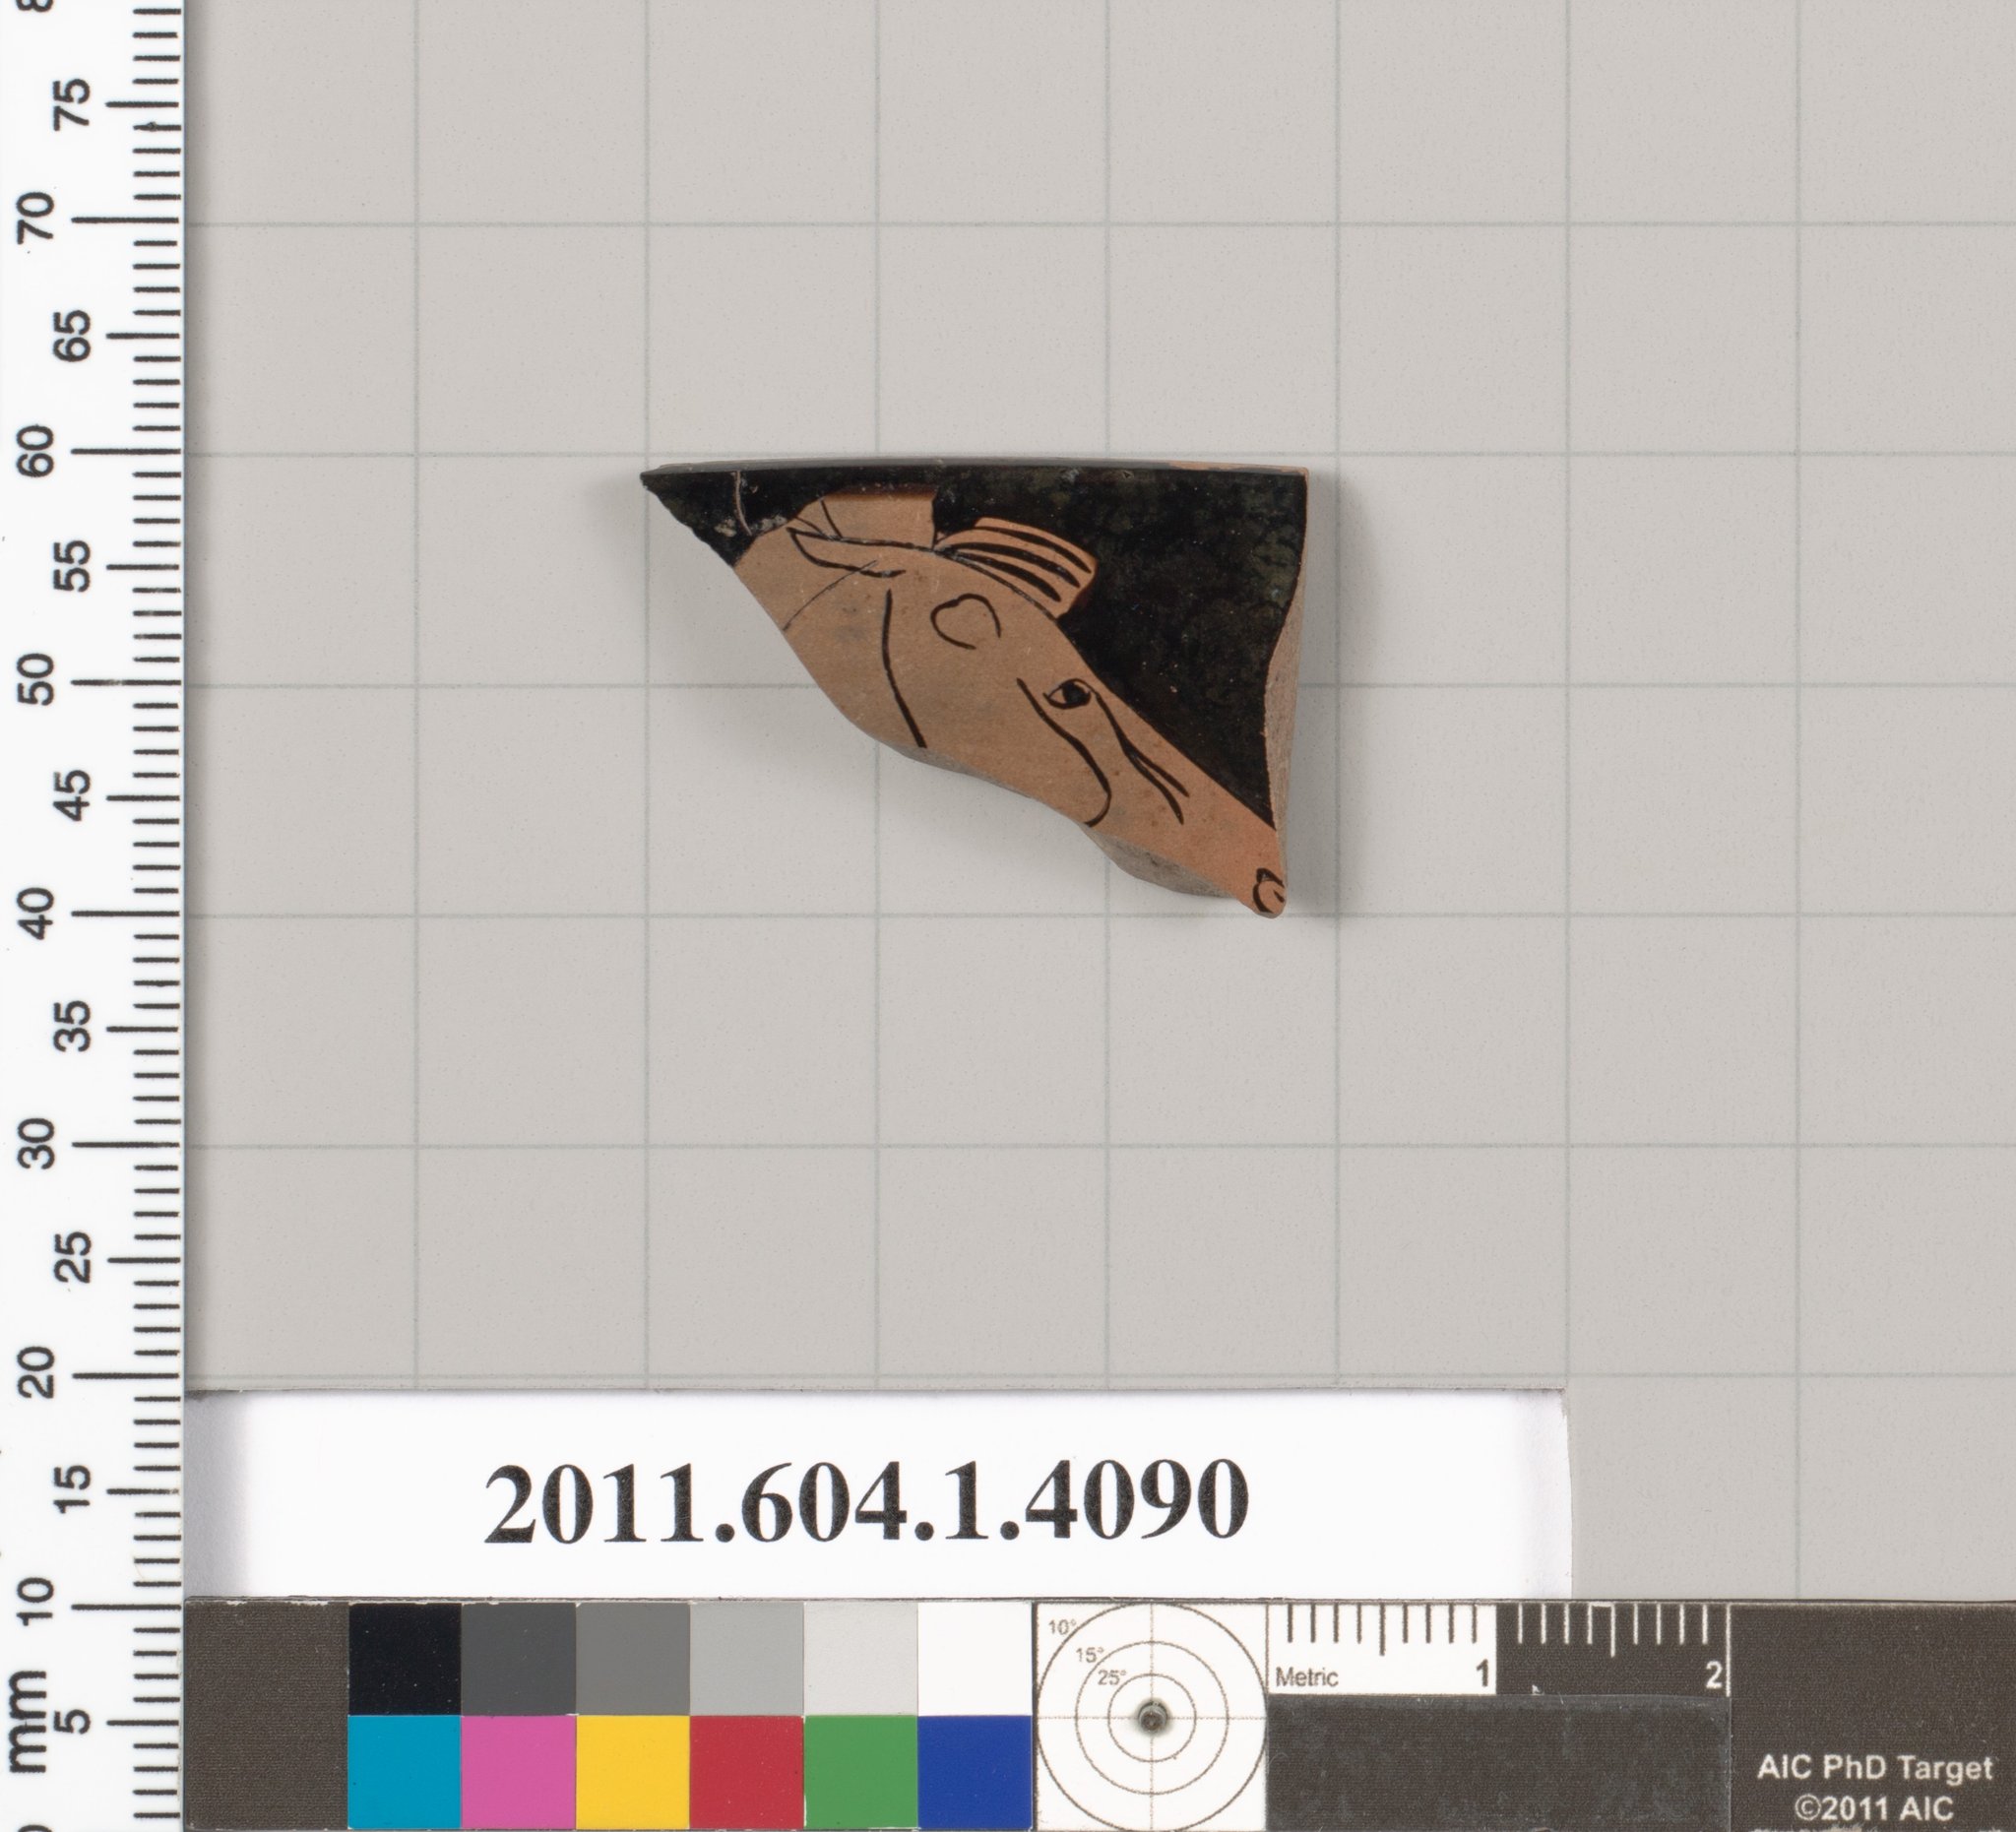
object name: kylix fragment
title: Terracotta rim fragment of a kylix (drinking cup)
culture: greek, attic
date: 520-500 BCE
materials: terracotta